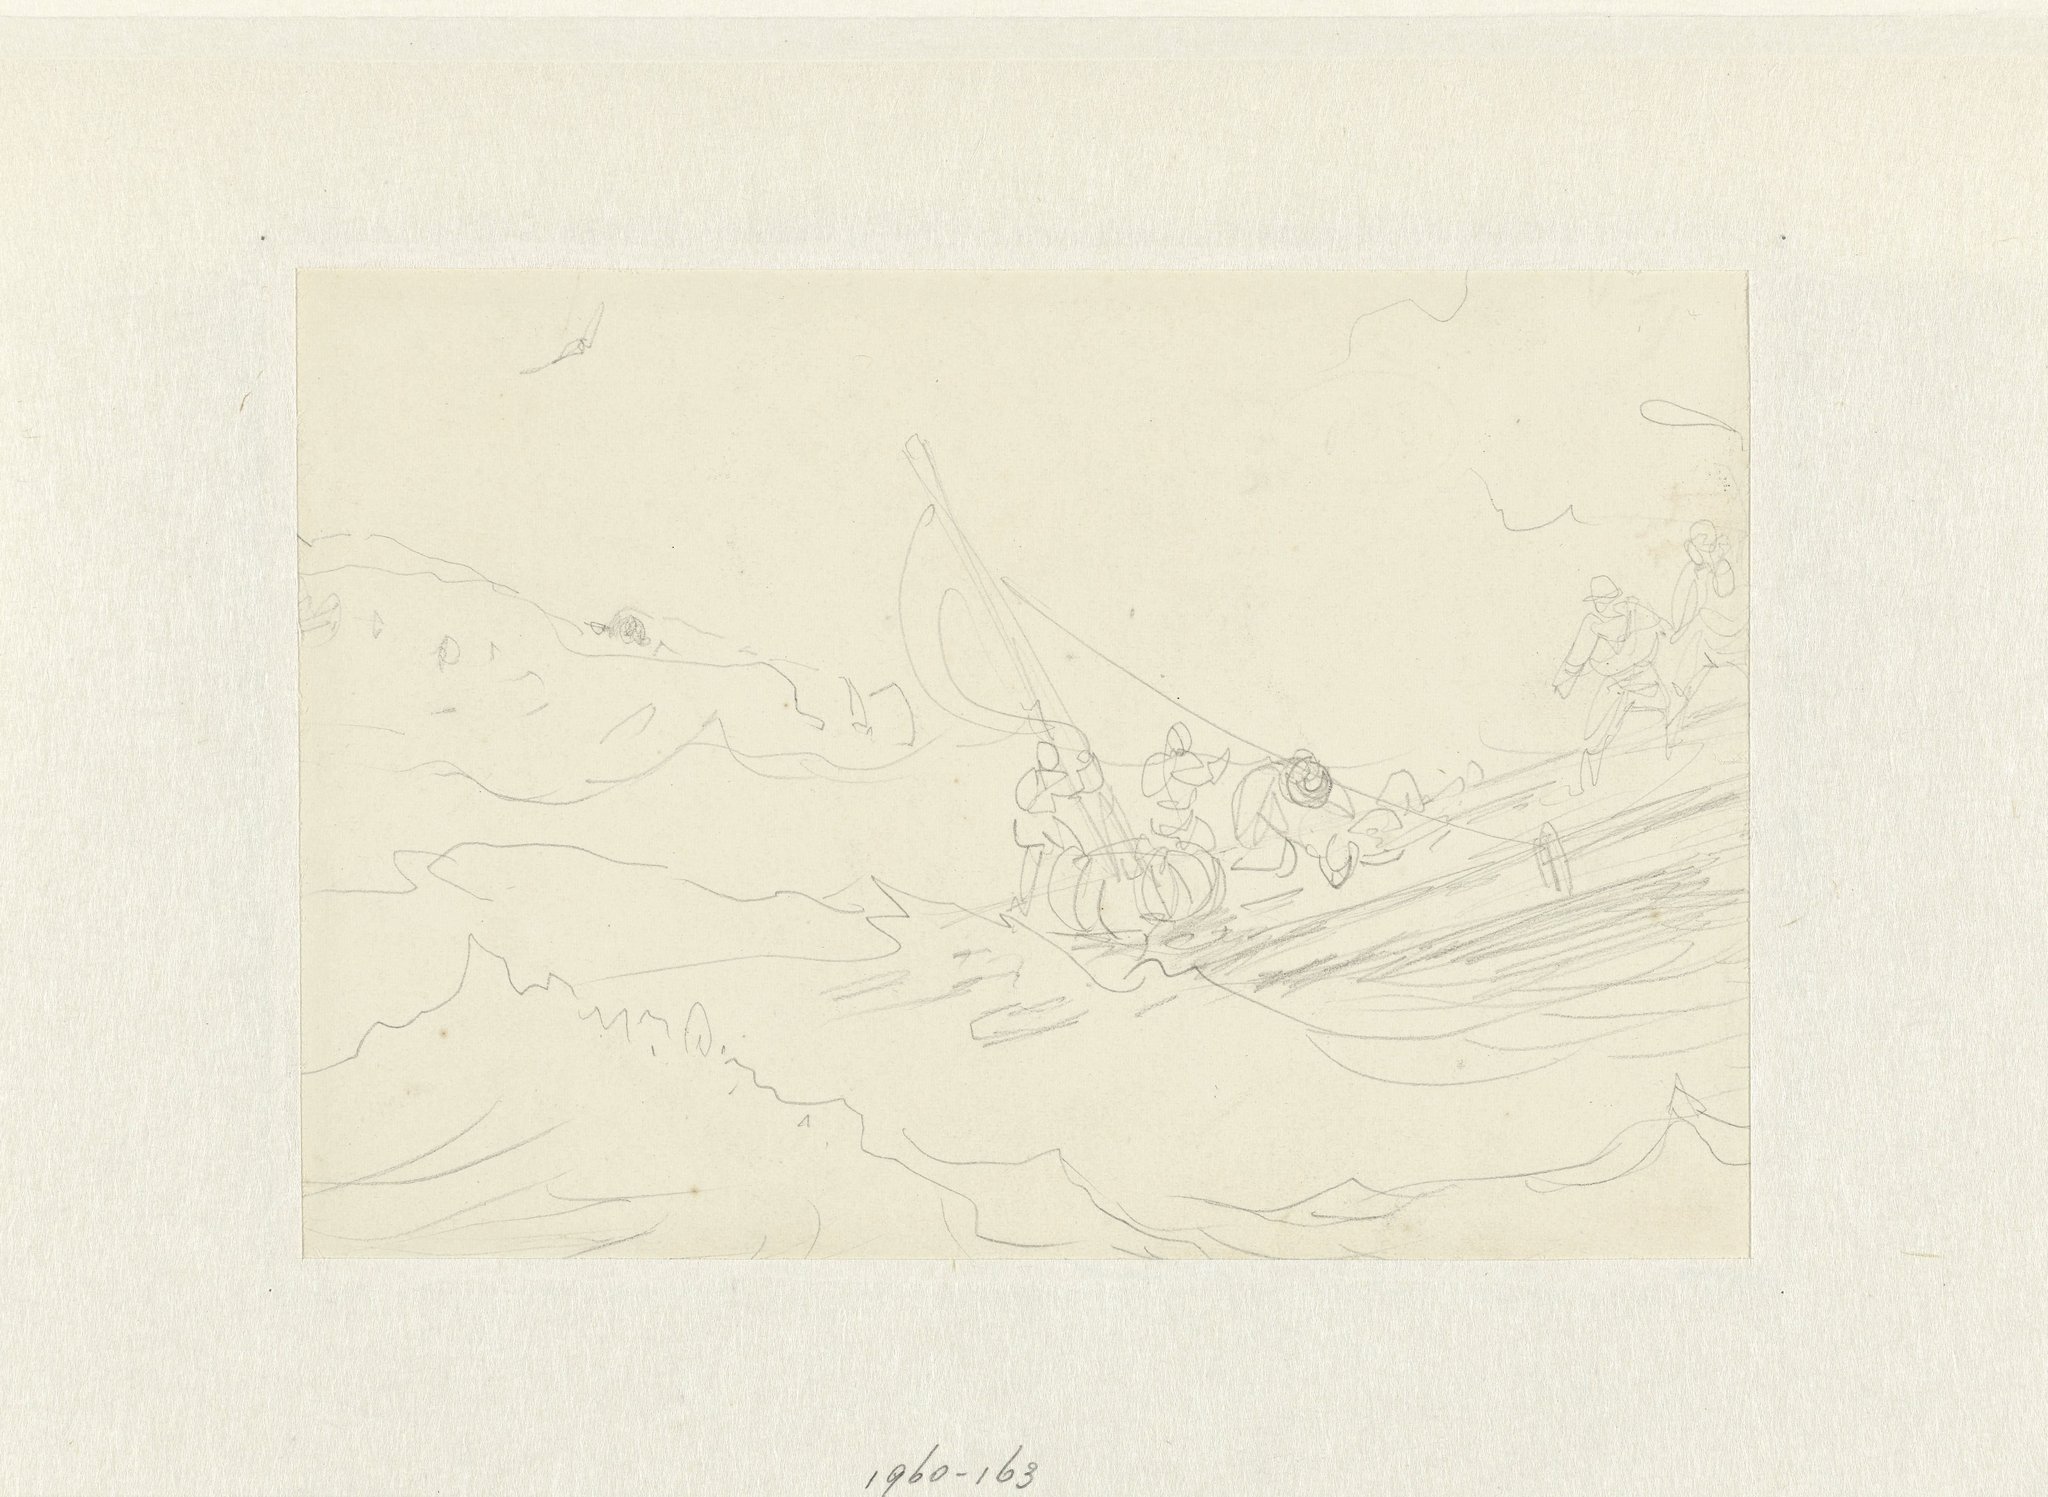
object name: drawing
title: Schets van een schipbreuk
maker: johannes franciscus hoppenbrouwers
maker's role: draughtsman, painter, print maker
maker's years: 1819-1866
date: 1829-1866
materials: paper, pencil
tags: shipwreck